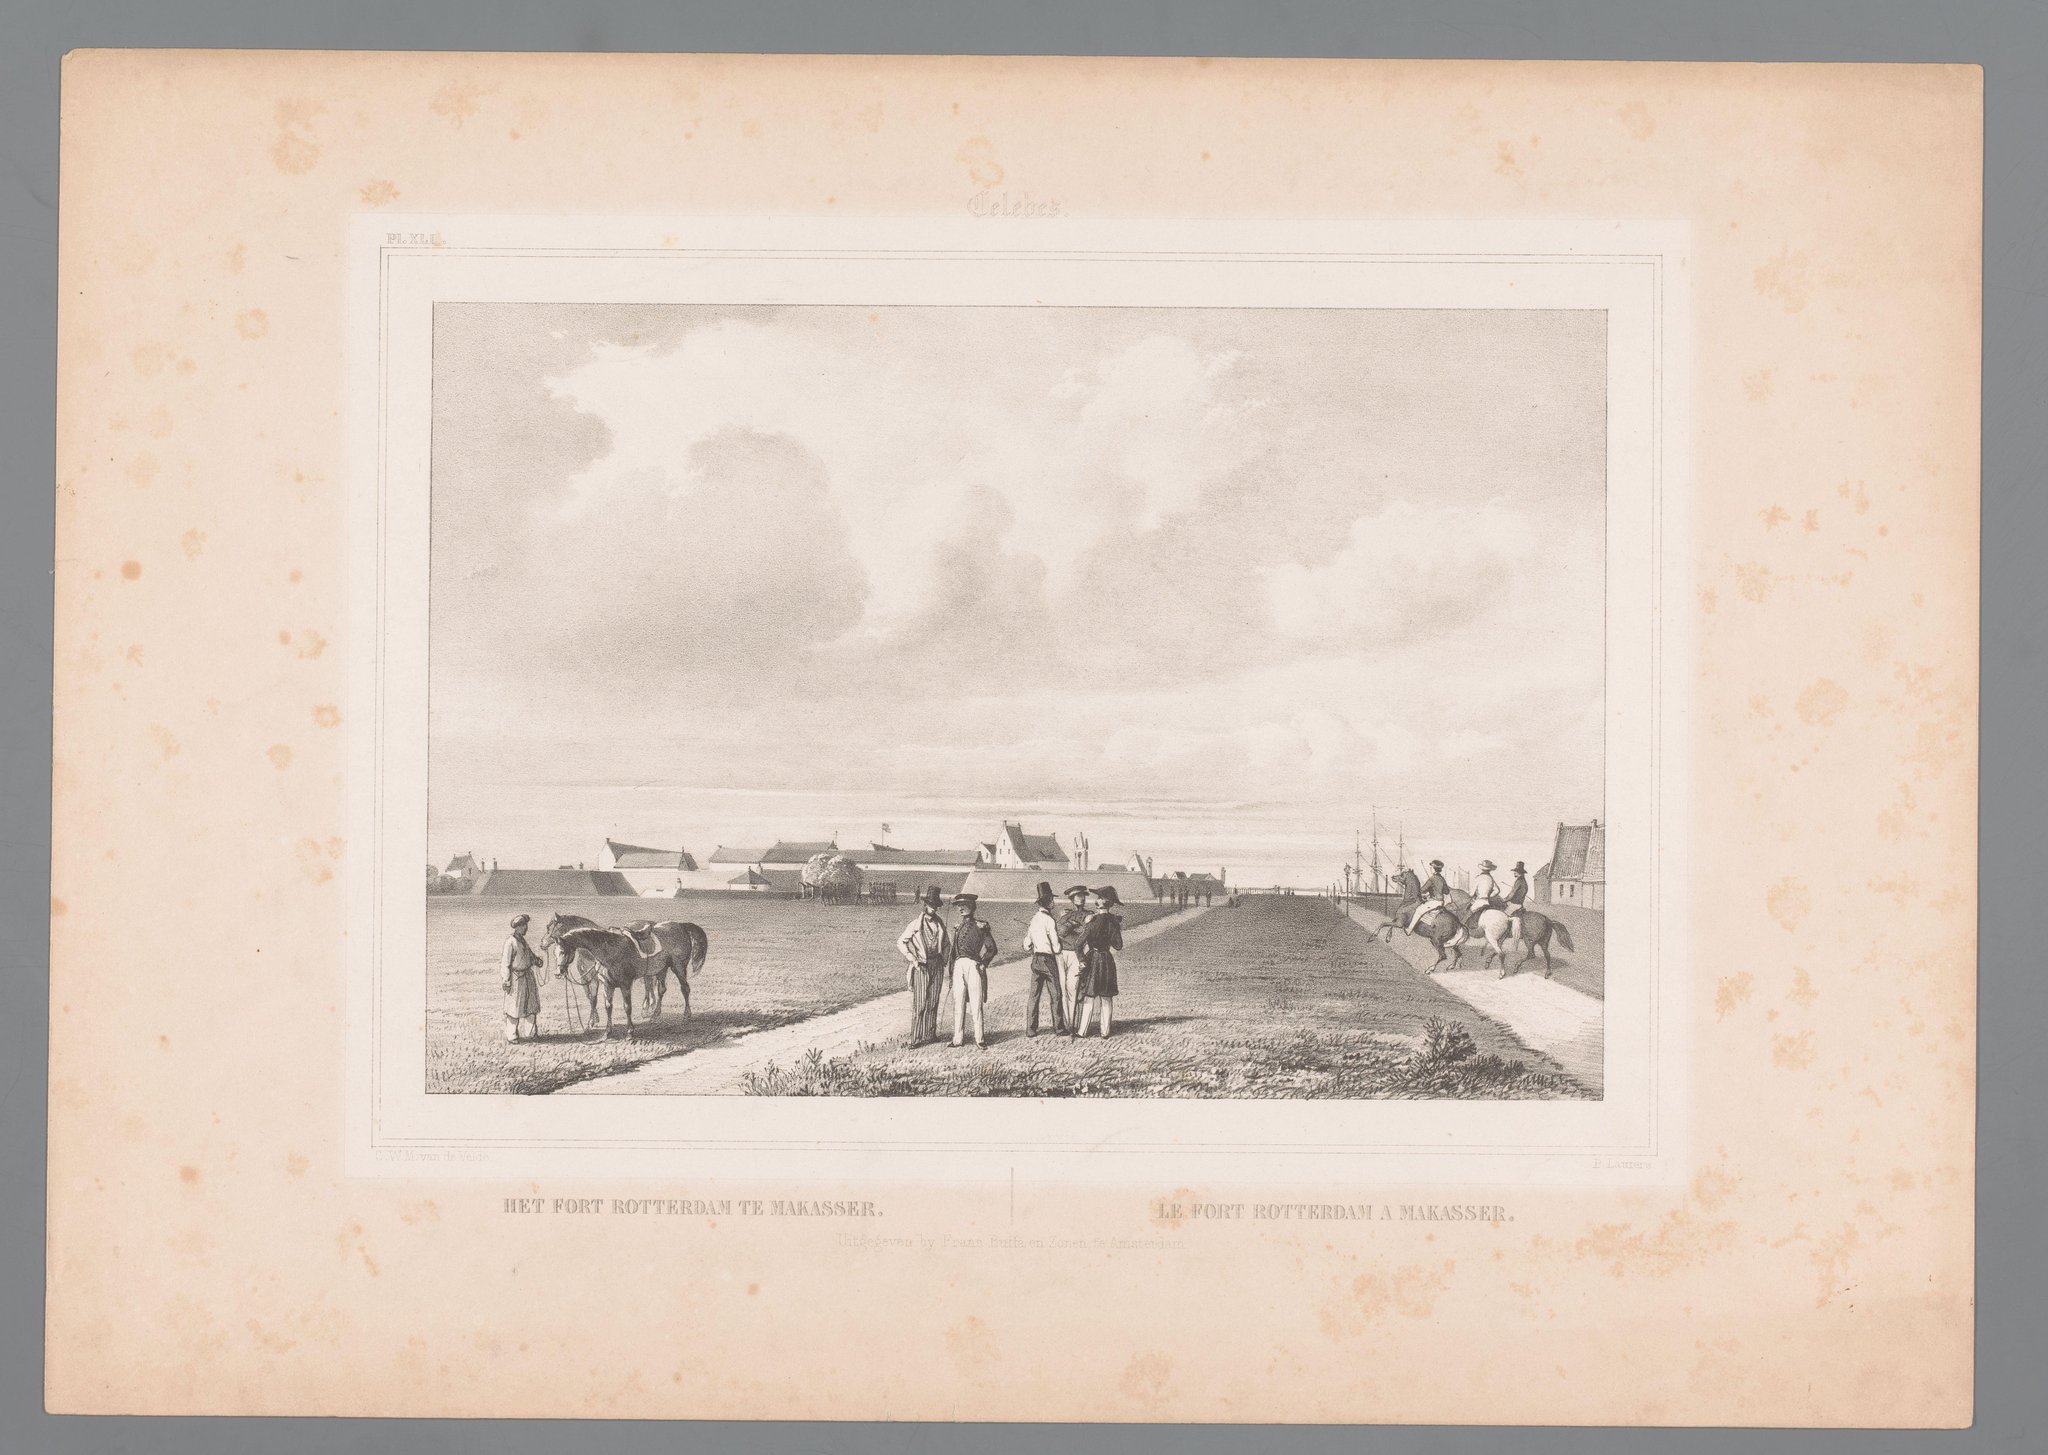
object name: print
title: Gezigten uit Neêrlands Indië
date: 1847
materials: paper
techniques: lithograph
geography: amsterdam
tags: riding a horse, ass, or mule; rider, horseman, fortress, standing figure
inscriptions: inscription: ‘18; 2487-1909’, stamp: ‘Koloniaal Museum Haarlem’, label: ‘Koloniaal Instituut - Amsterdam; No. 1804; Doos No. 19’, collector's mark: Lugt 2228